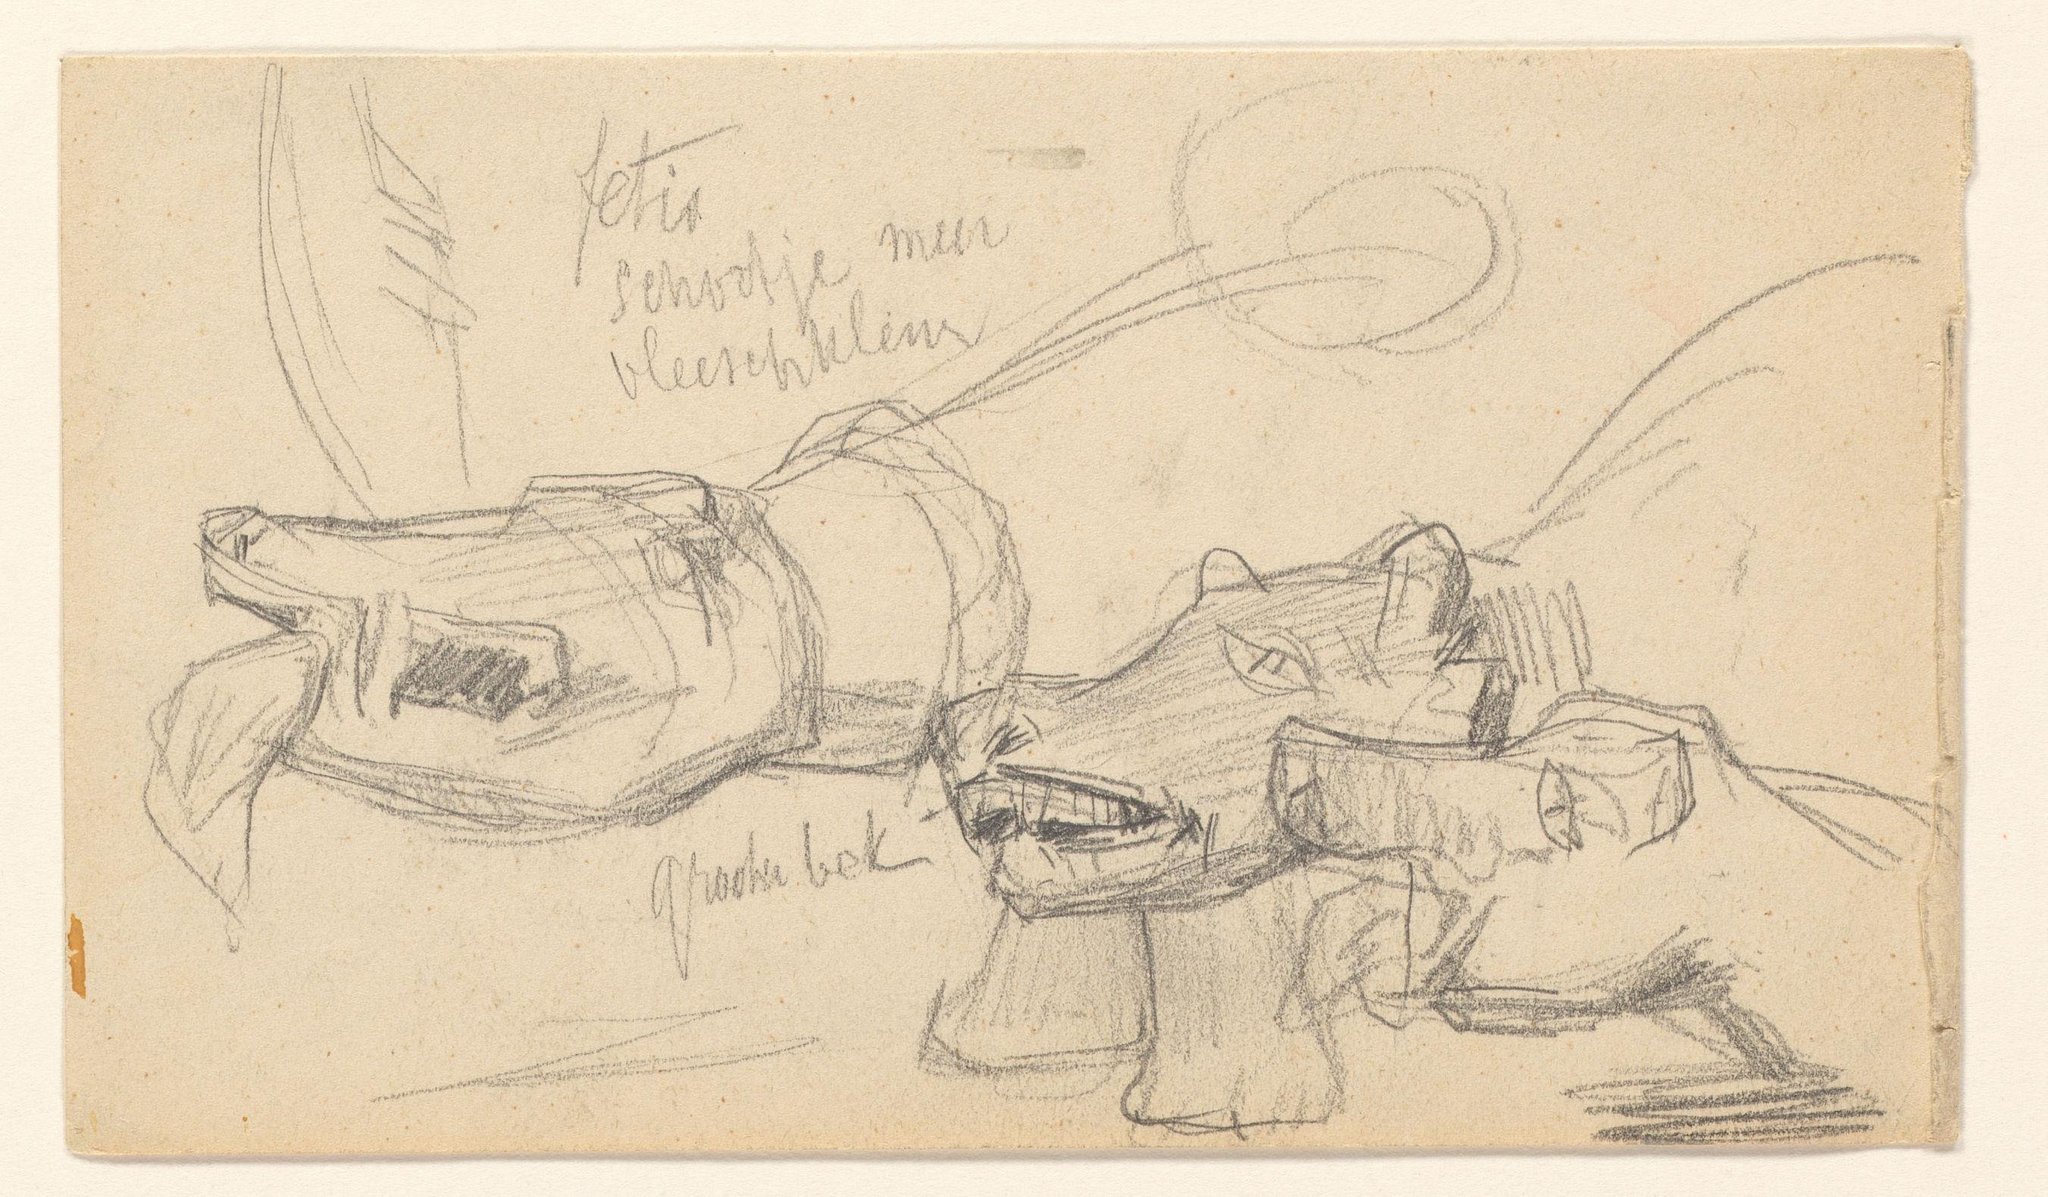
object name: drawing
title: Schets van drie beesten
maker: august allebé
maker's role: draughtsman, print maker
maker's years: 1838-1927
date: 1848-1927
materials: paper, pencil